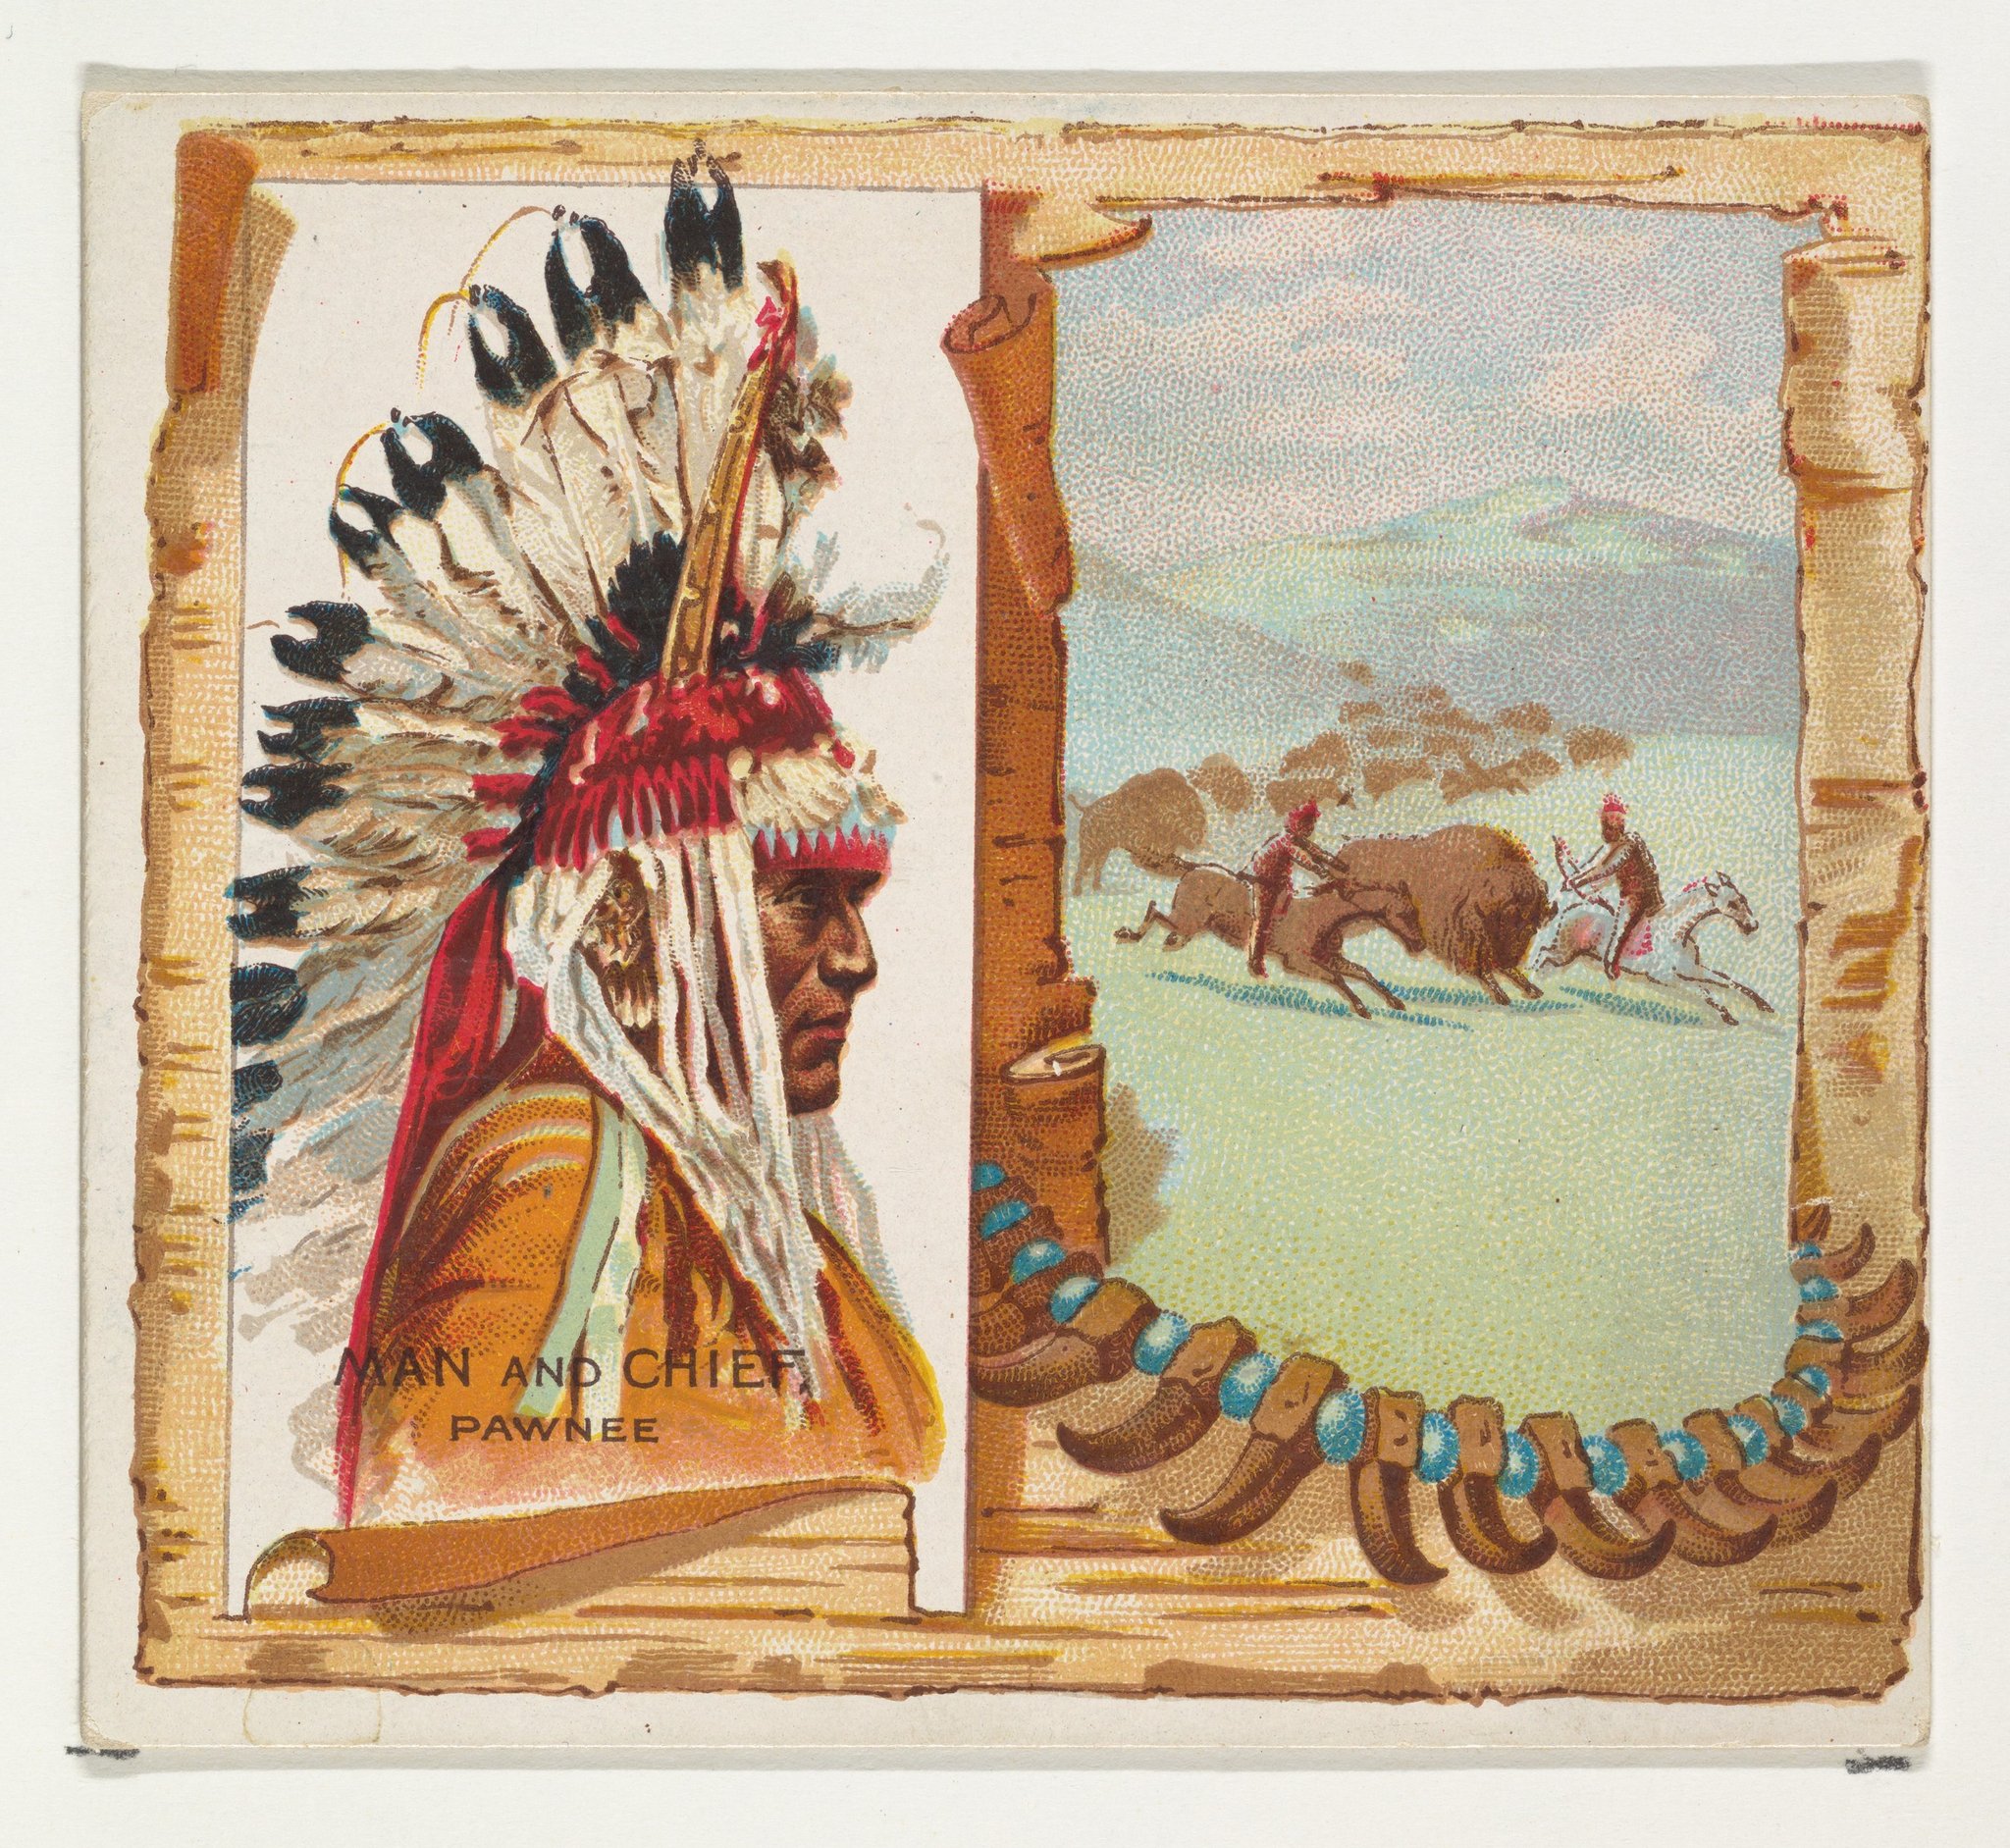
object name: print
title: Man and Chief, Pawnee, from the American Indian Chiefs series (N36) for Allen & Ginter Cigarettes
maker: allen & ginter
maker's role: publisher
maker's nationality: american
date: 1888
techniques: color lithograph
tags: men,profiles